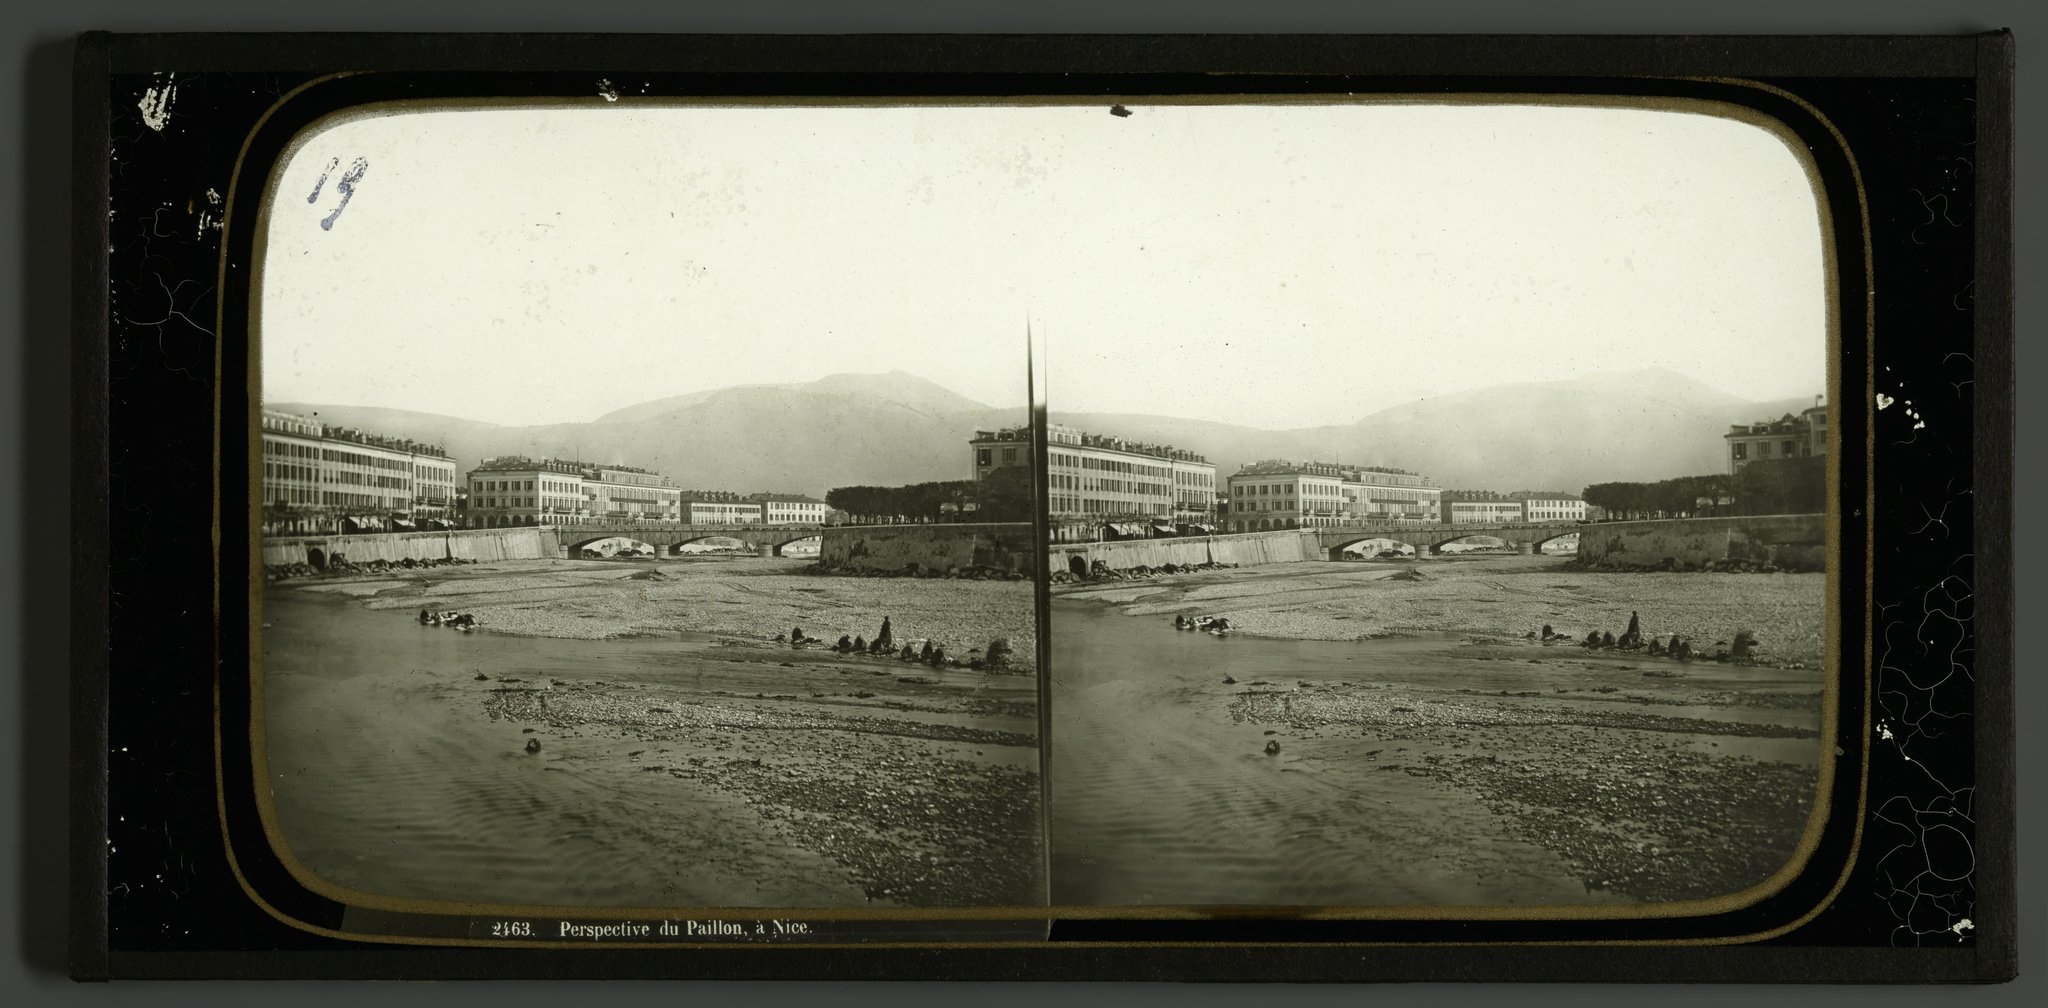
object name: stereoscopic photograph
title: Perspective du Paillon, à Nice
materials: glass, paper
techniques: slide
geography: nice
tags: river, prospect of city, town panorama, silhouette of city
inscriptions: number: ‘2463’, number: ‘19’